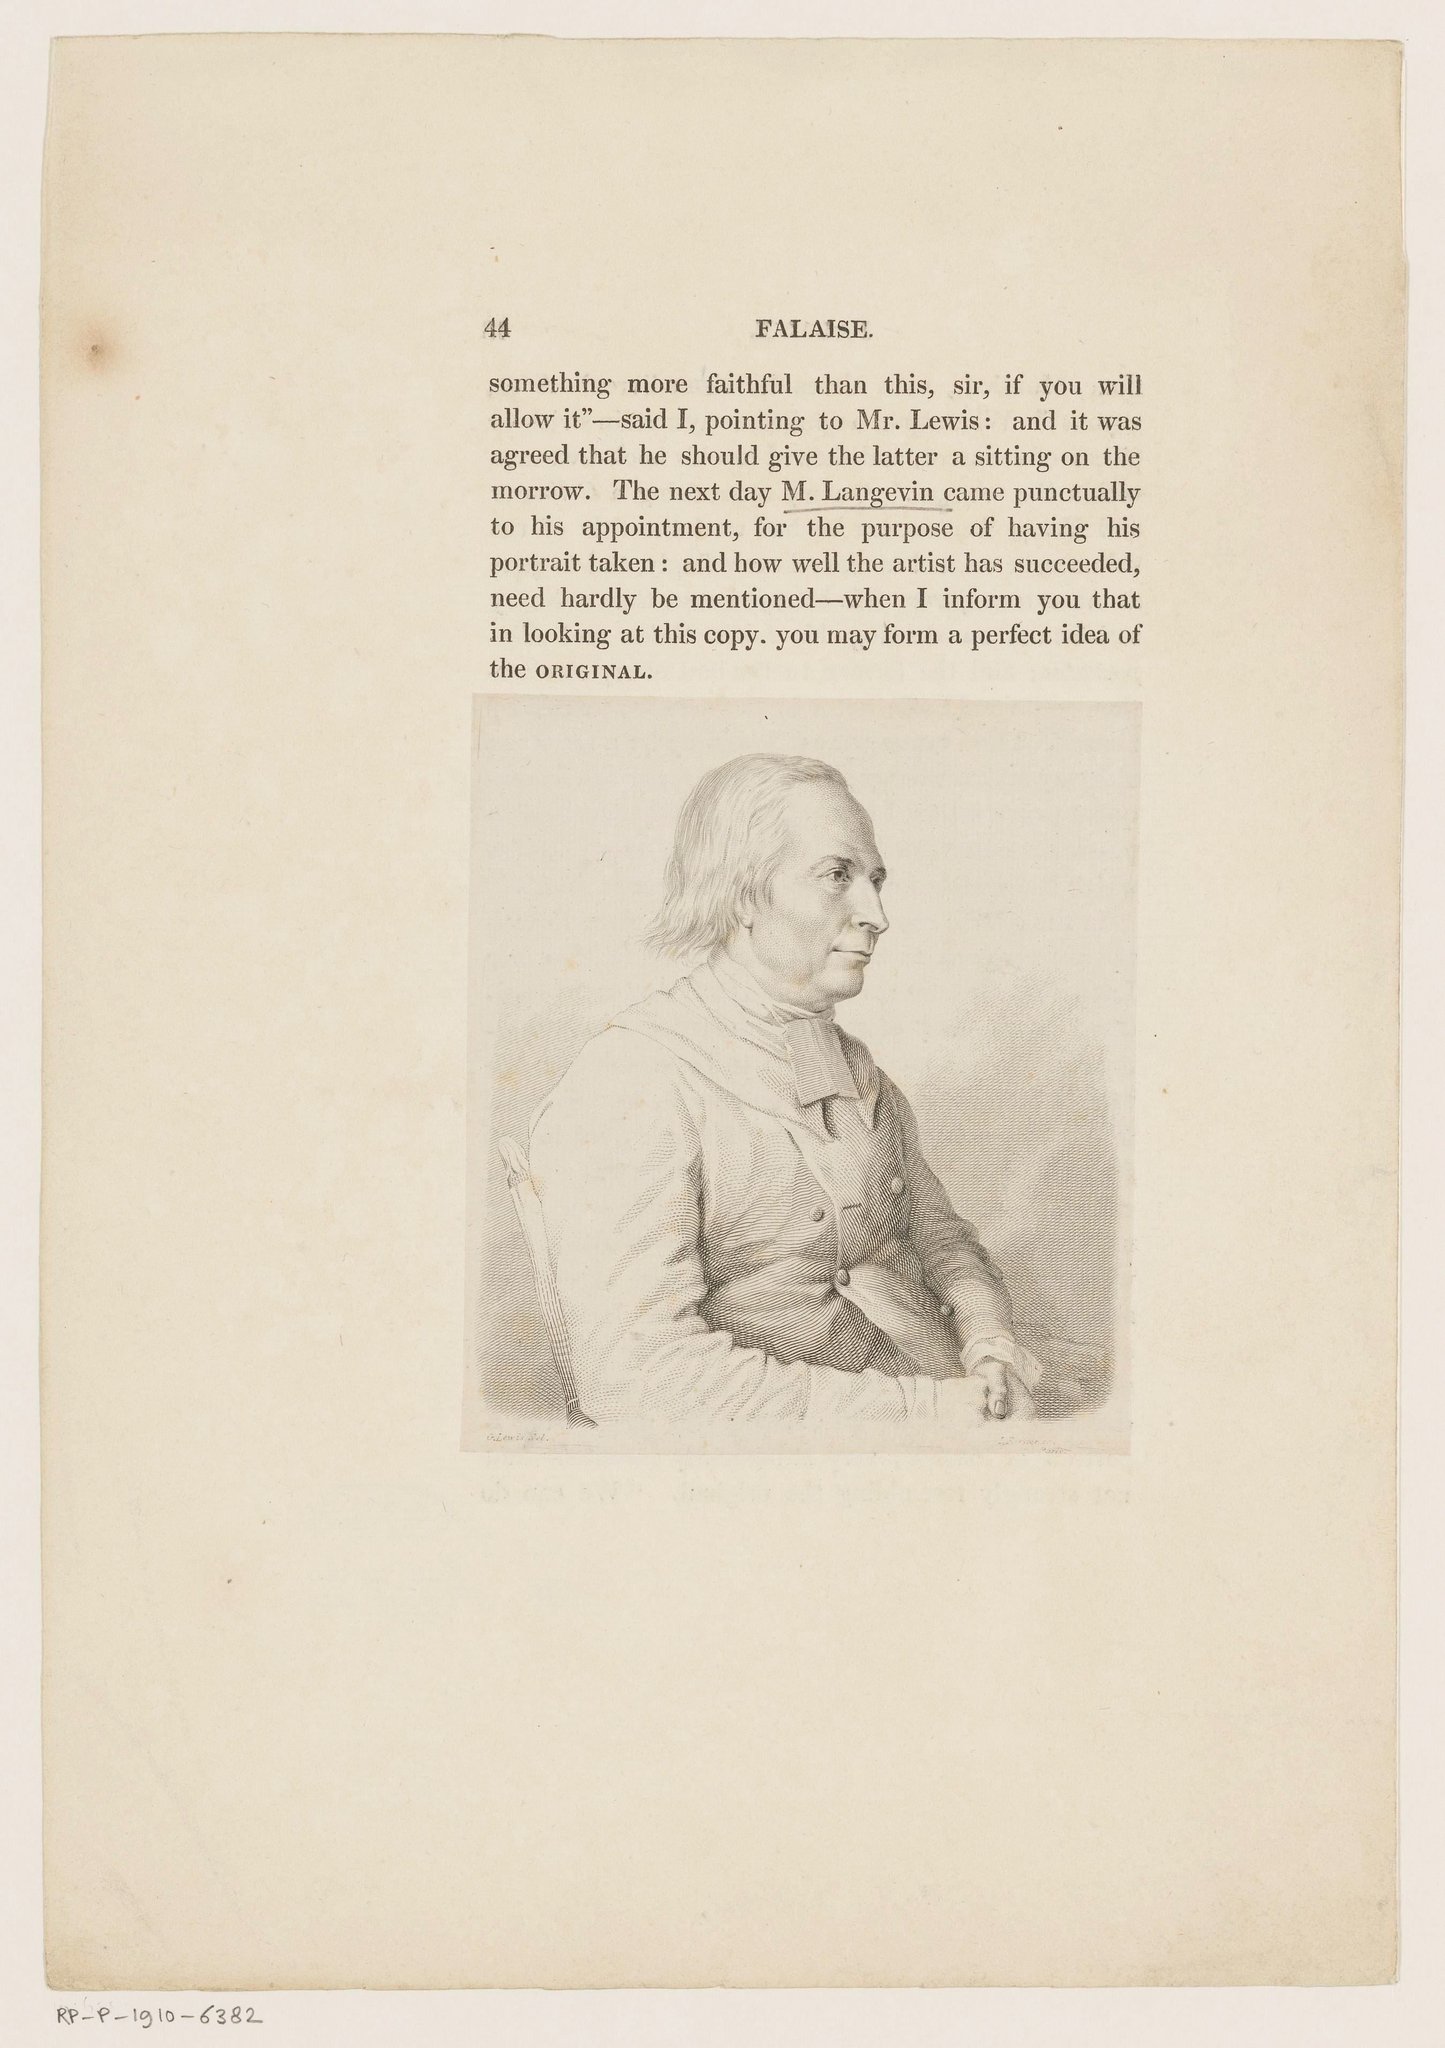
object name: book illustration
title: Portret van Monsieur Langevin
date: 1821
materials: paper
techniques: engraving, letterpress printing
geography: paris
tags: print maker, langevin, historical persons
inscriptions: collector's mark: Lugt 2228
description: Prent uit: Dibdin, Thomas Frognall. A Bibliographical, Antiquarian and Picturesque Tour in France and Germany. Londen: s.n., 1821, dl. 2, p. 44.